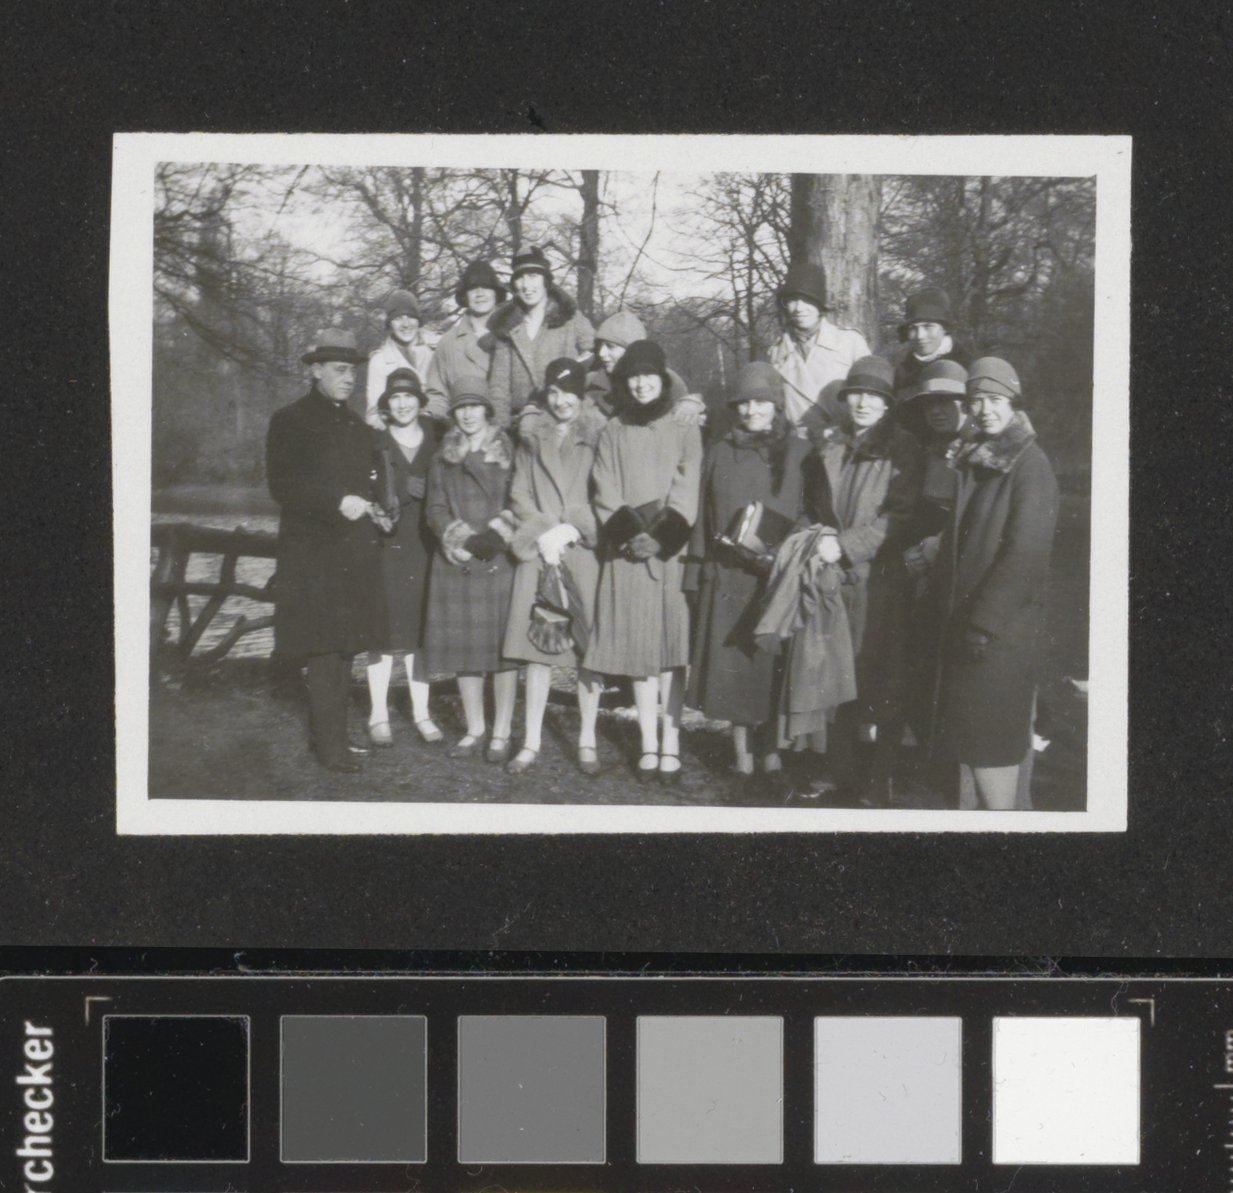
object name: photograph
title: Groepsportret van de leerlingen van de 22e cursus van de Koloniale School voor Meisjes en Vrouwen in Den Haag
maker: Anonymous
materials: photographic support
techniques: photography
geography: the hague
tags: further education (+ pupil), further education, the hague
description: Onderdeel van Stamboek van de leerlingen der Koloniale School voor Meisjes en Vrouwen te 's-Gravenhage deel I (1921-1929).